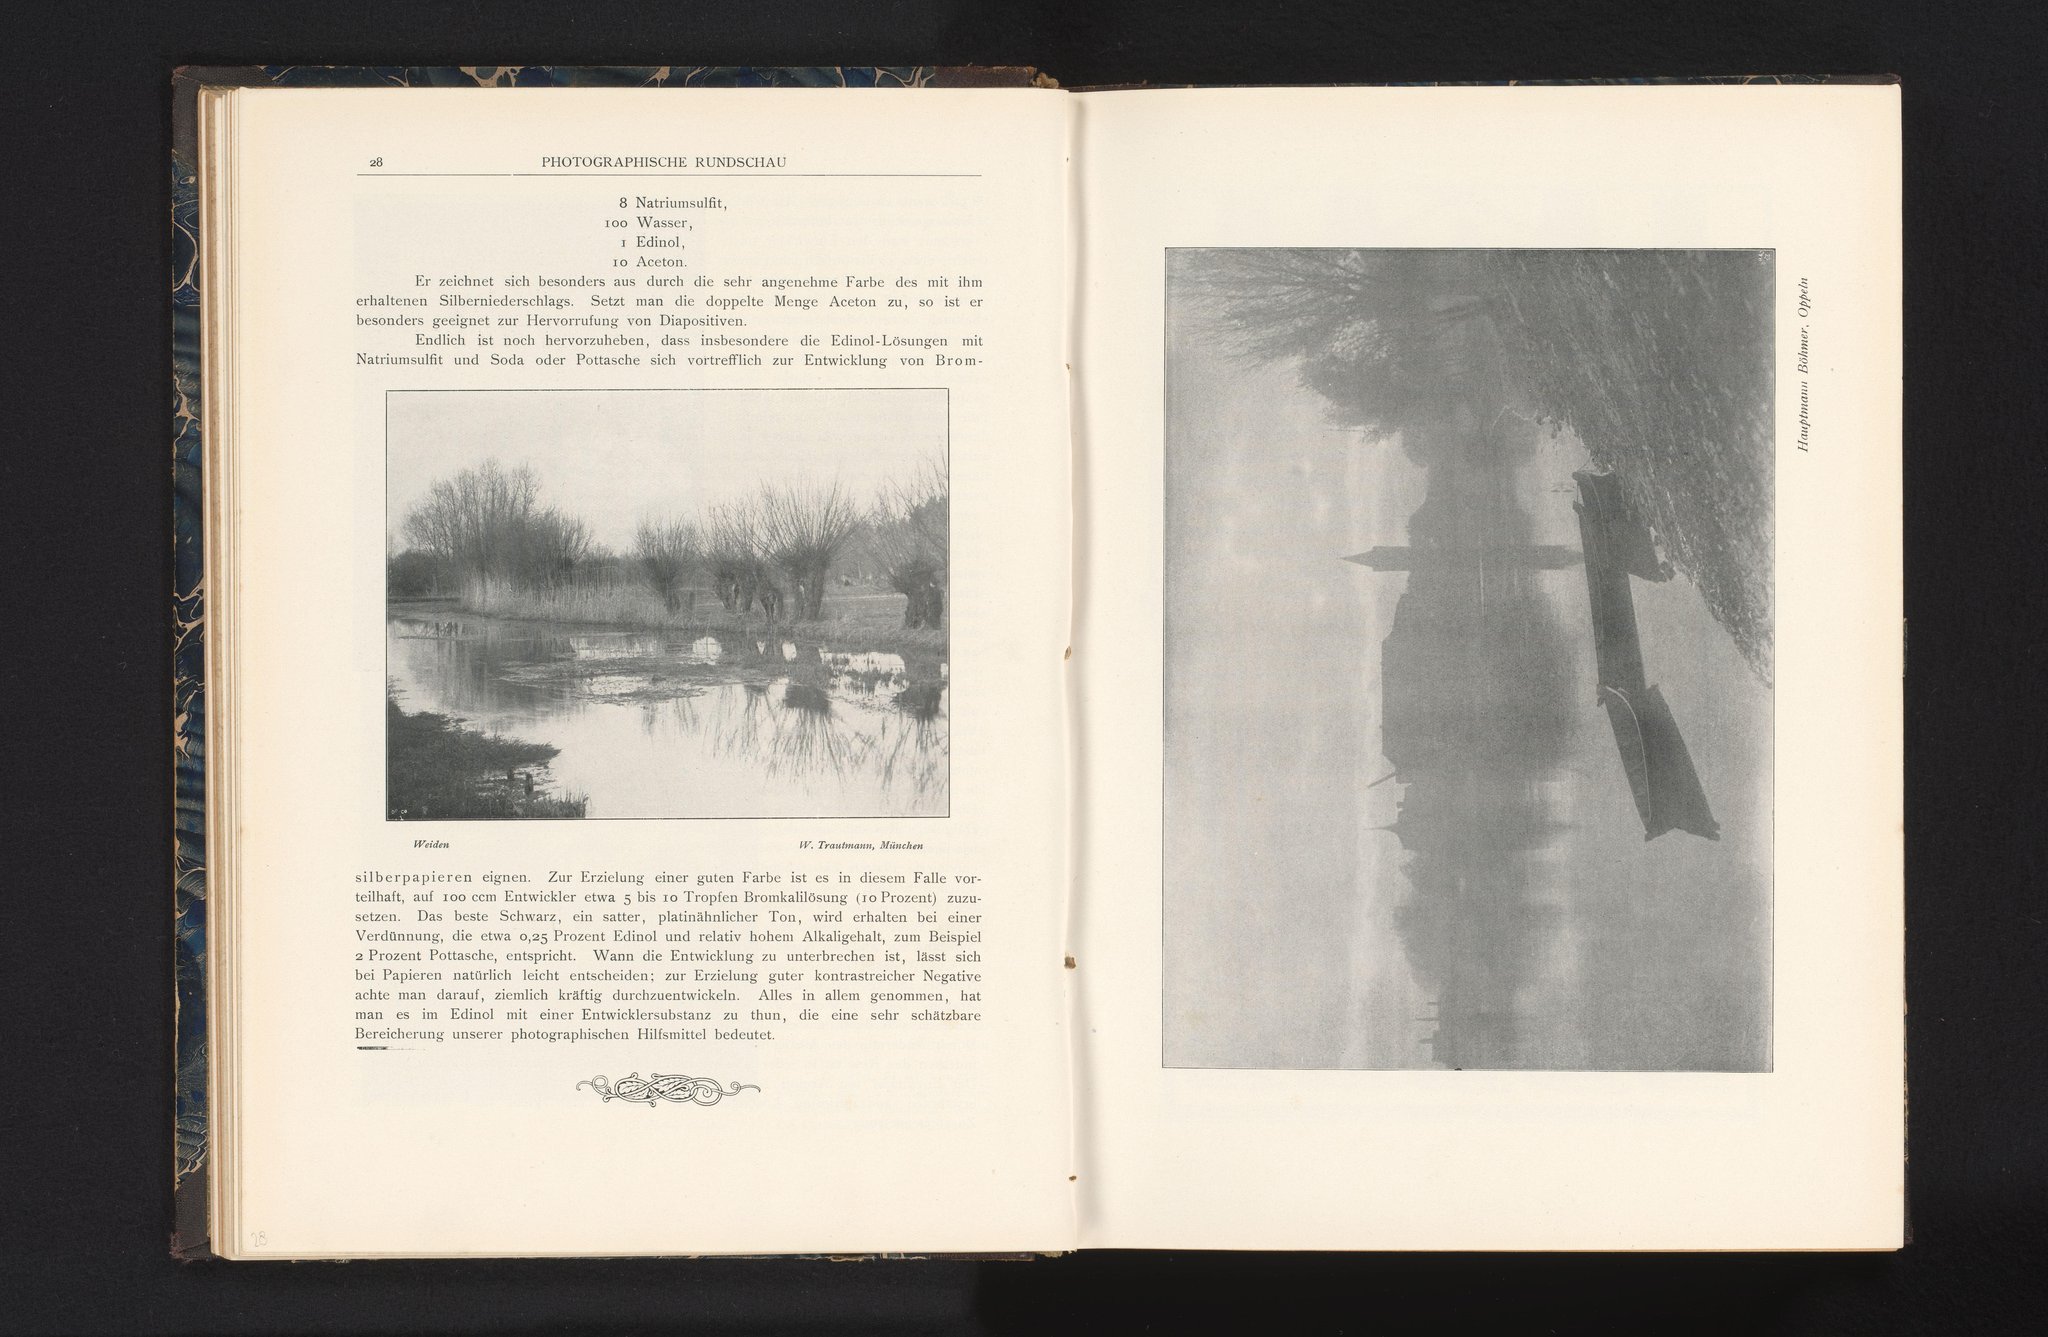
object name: photomechanical print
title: Gezicht op bootjes in het water met op de achtergrond een dorp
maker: hauptmann a. böhmer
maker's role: draughtsman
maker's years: 1860-1908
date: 1897-1902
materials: paper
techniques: autotype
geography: berlin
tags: prospect of village, silhouette of village, landscapes with waters, waterscapes, seascapes (in the temperate zone), rowing-boat, canoe, etc.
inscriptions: monogram: ‘MR&C’